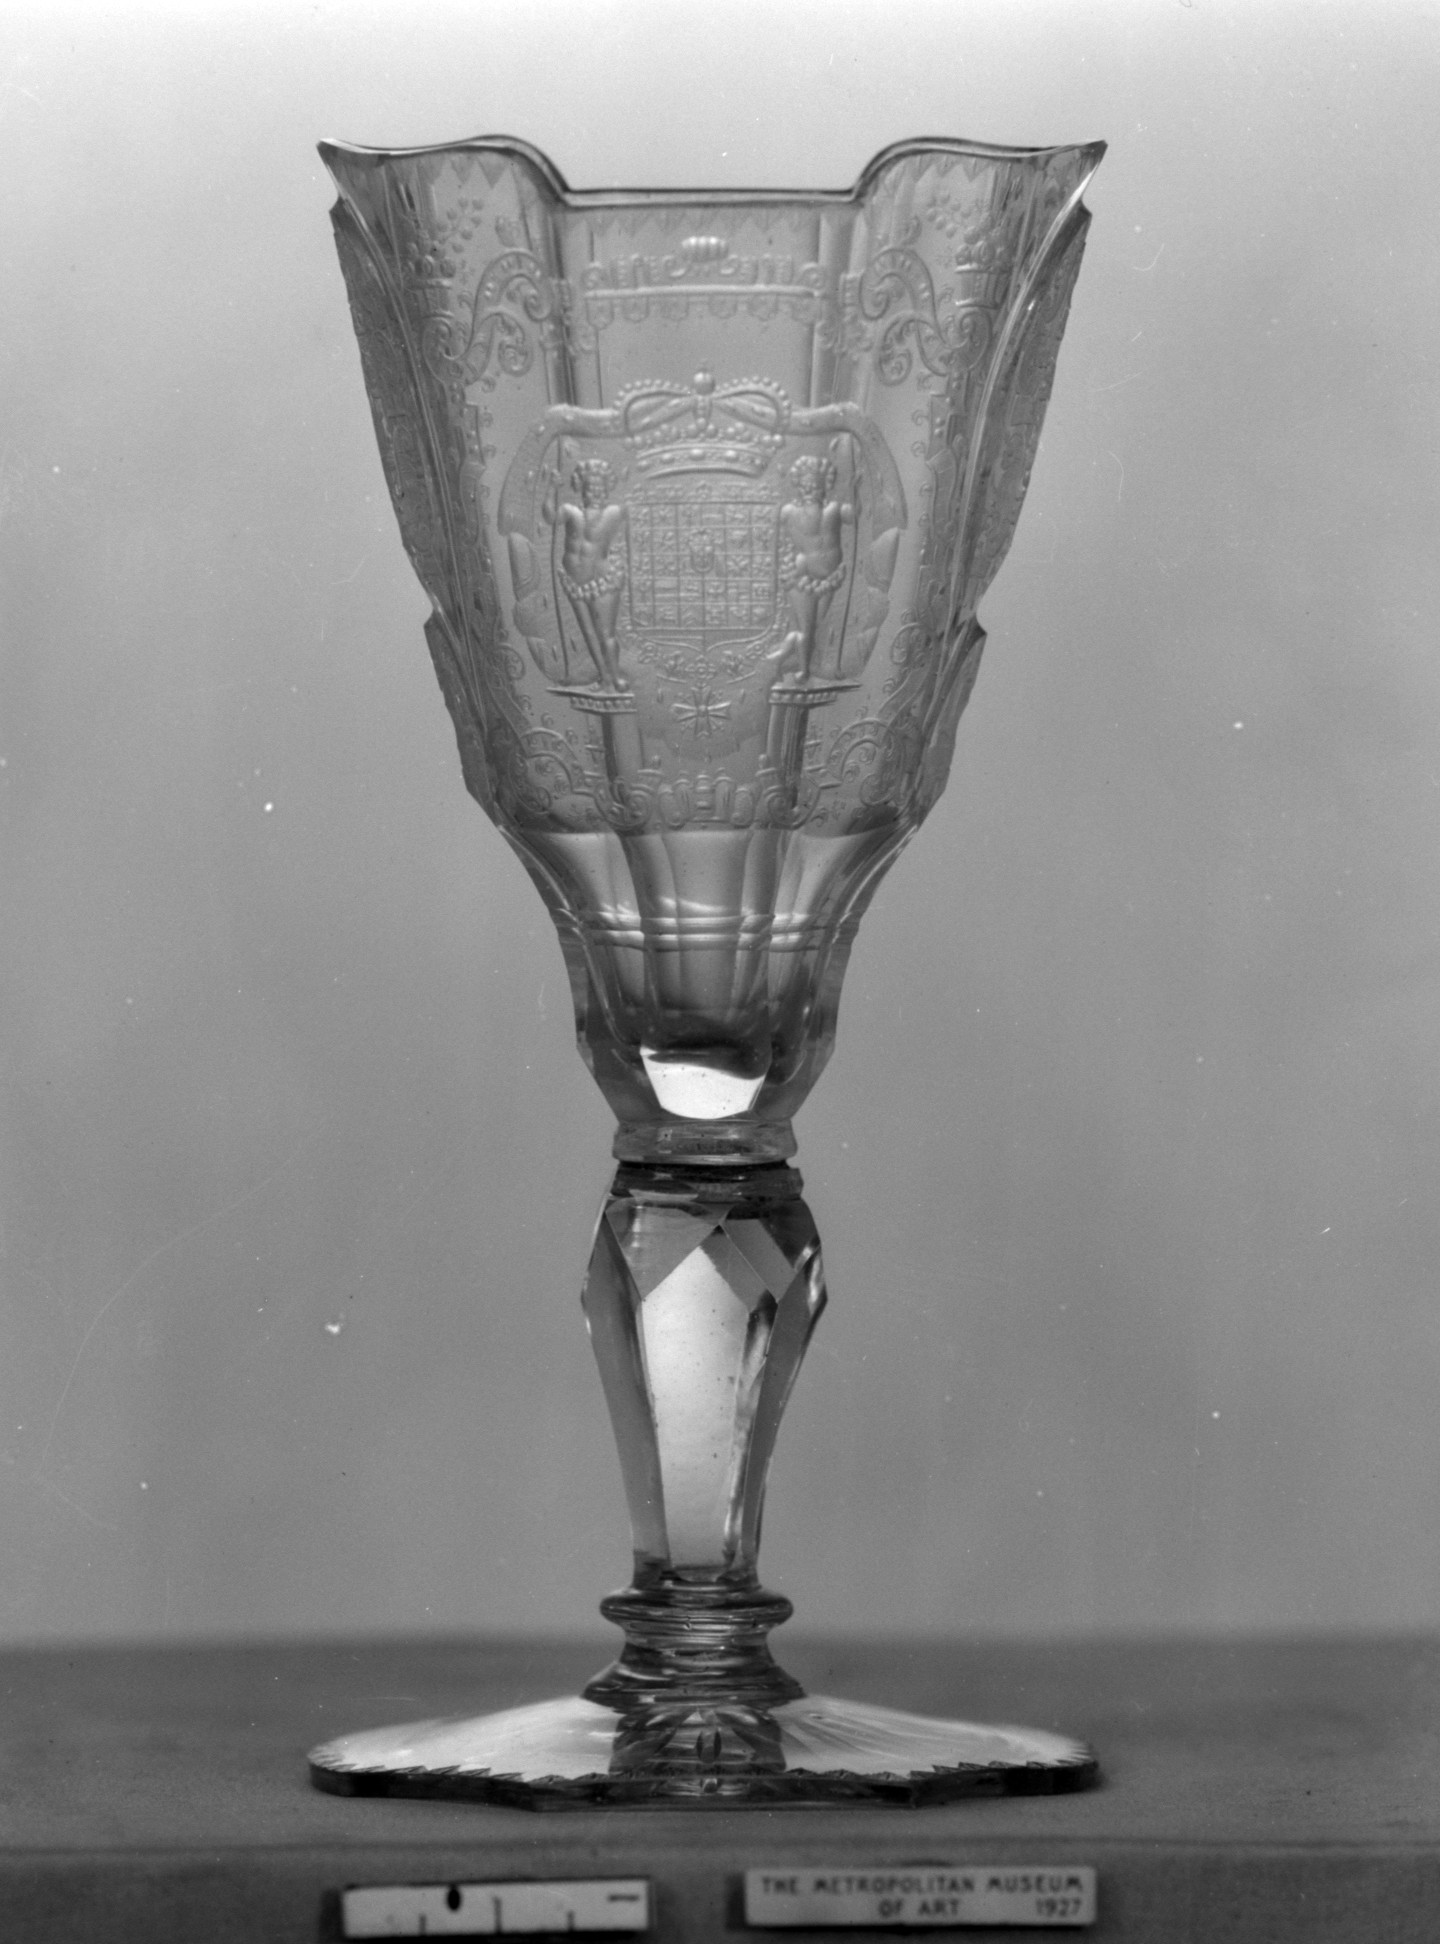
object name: wineglass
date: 1740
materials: glass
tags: coat of arms